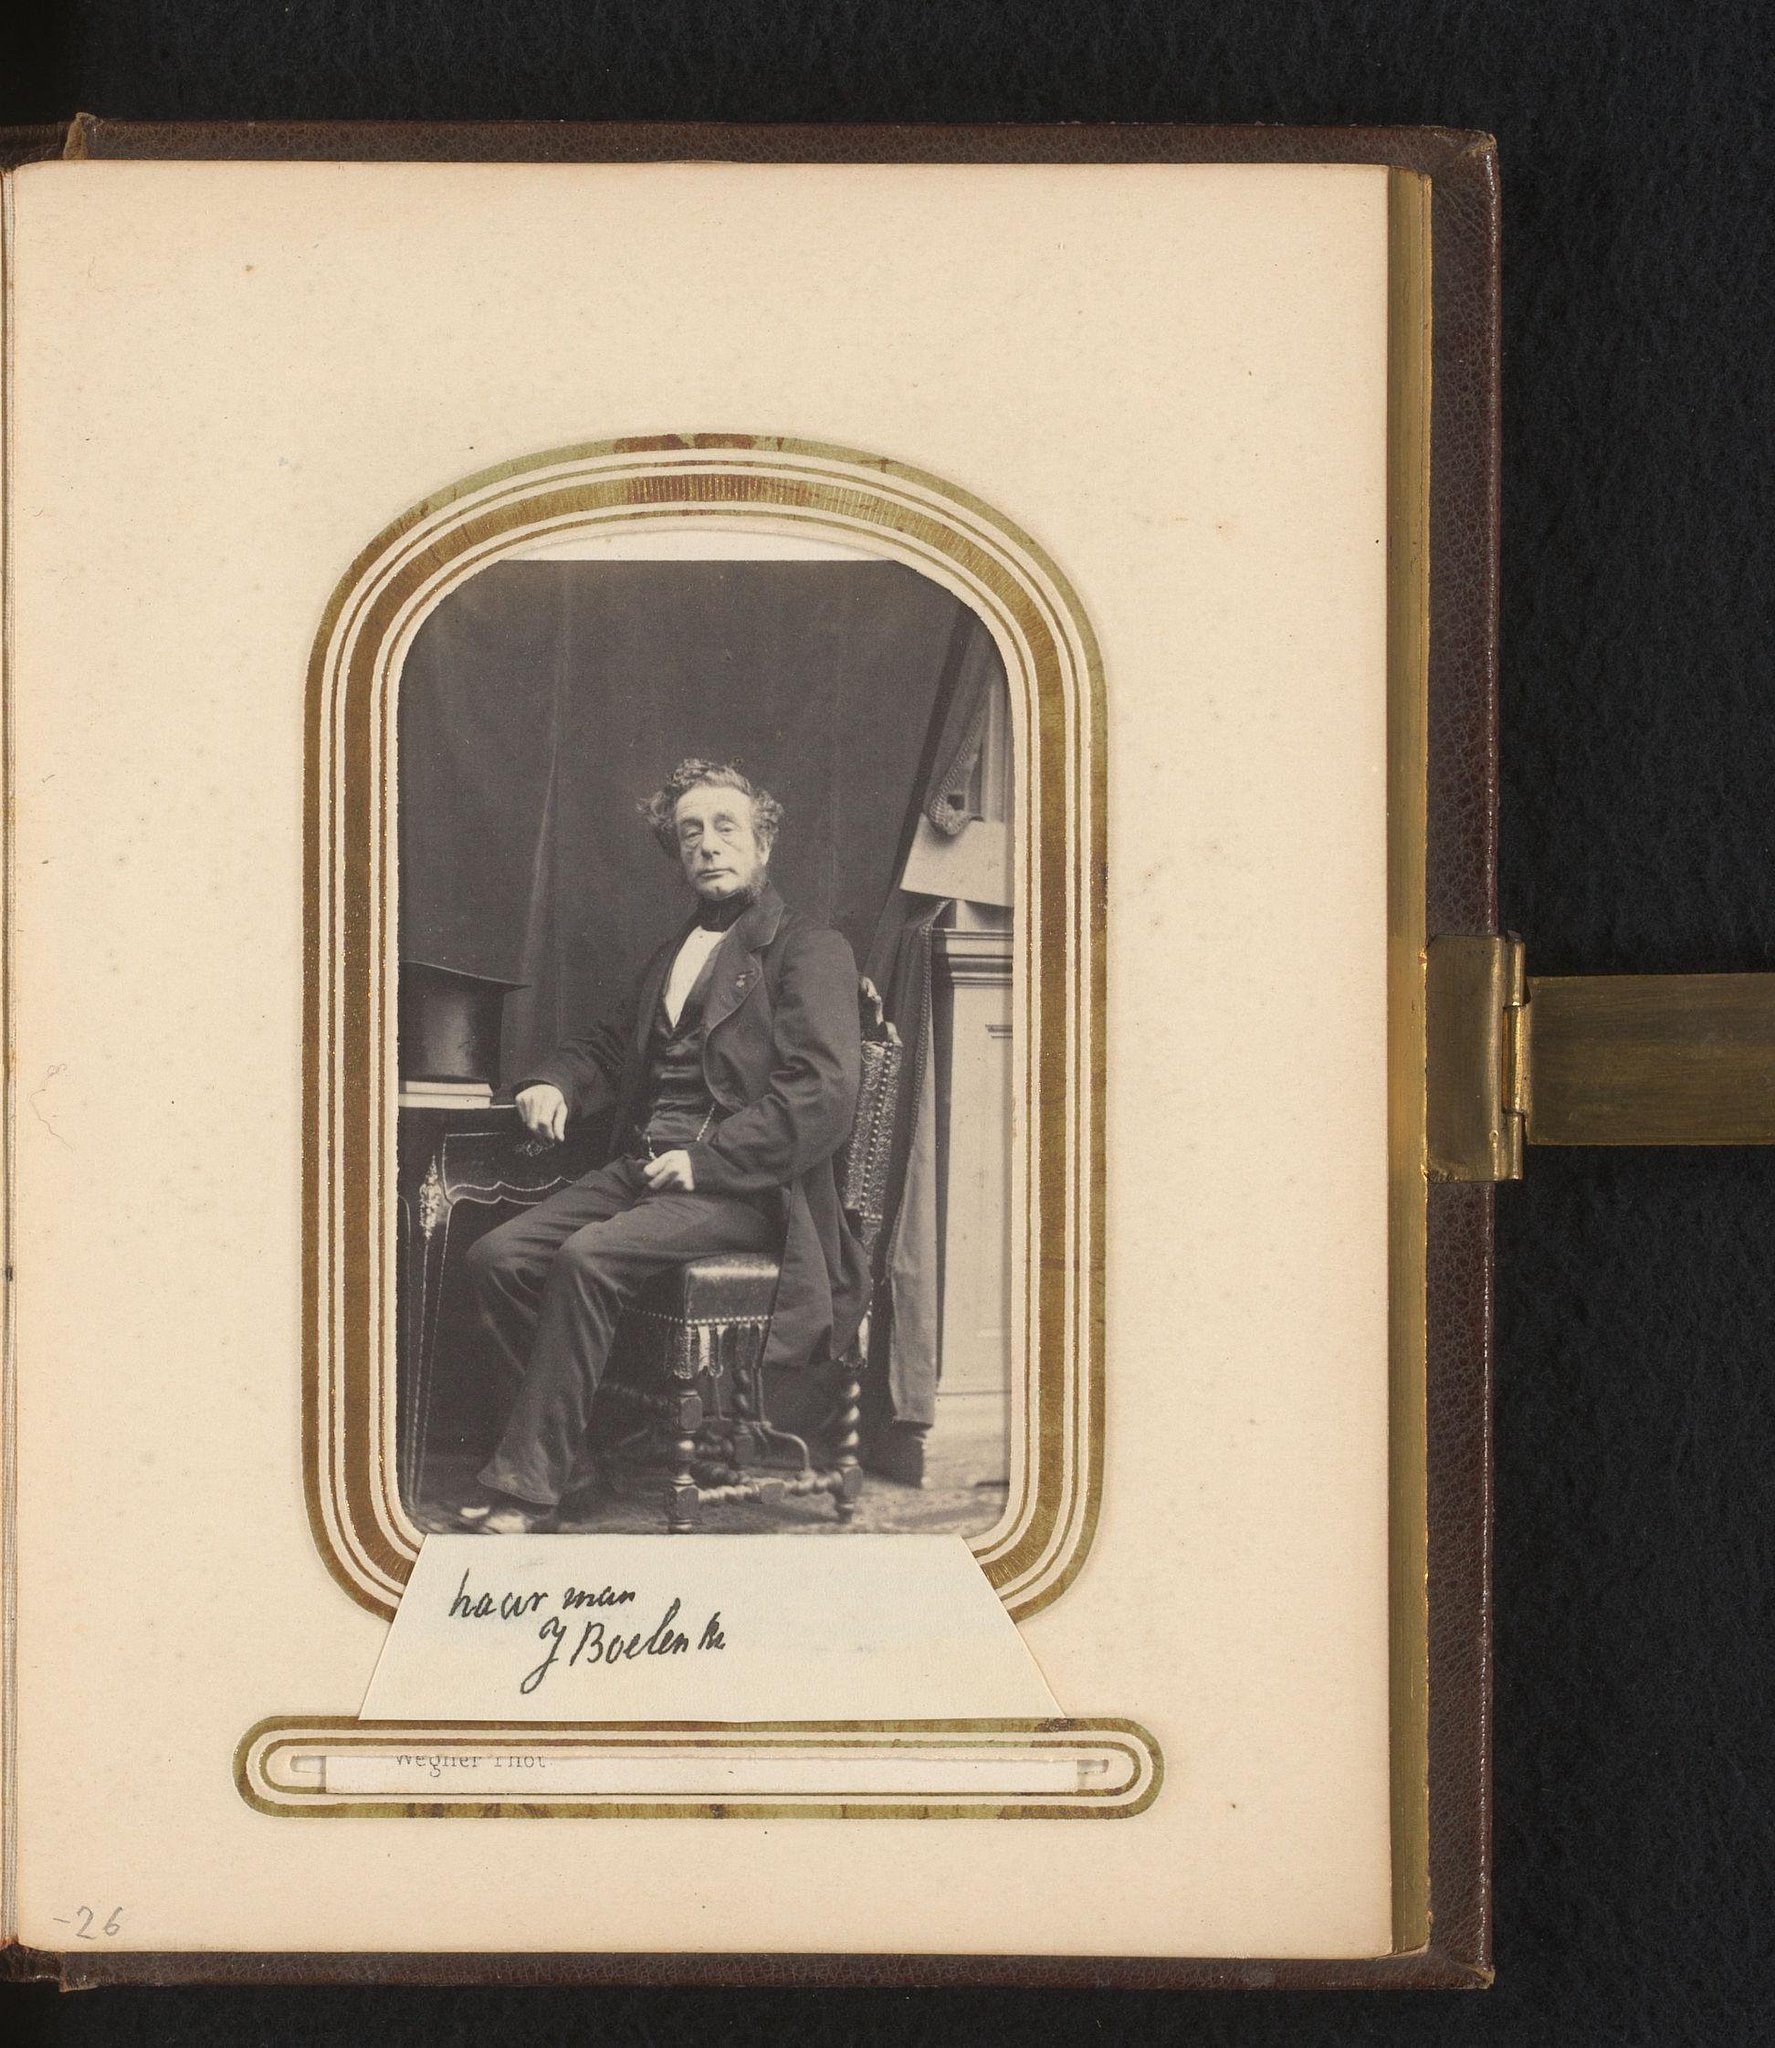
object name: album leaf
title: Portret van Jacobus Boelen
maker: louis wegner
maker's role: print maker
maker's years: 1816-1864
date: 1857-1864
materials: cardboard, paper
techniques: albumen print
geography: amsterdam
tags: amsterdam, utrecht, jacobus boelen, historical persons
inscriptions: address: ‘Prinsengracht BB 439/ AMSTERDAM’